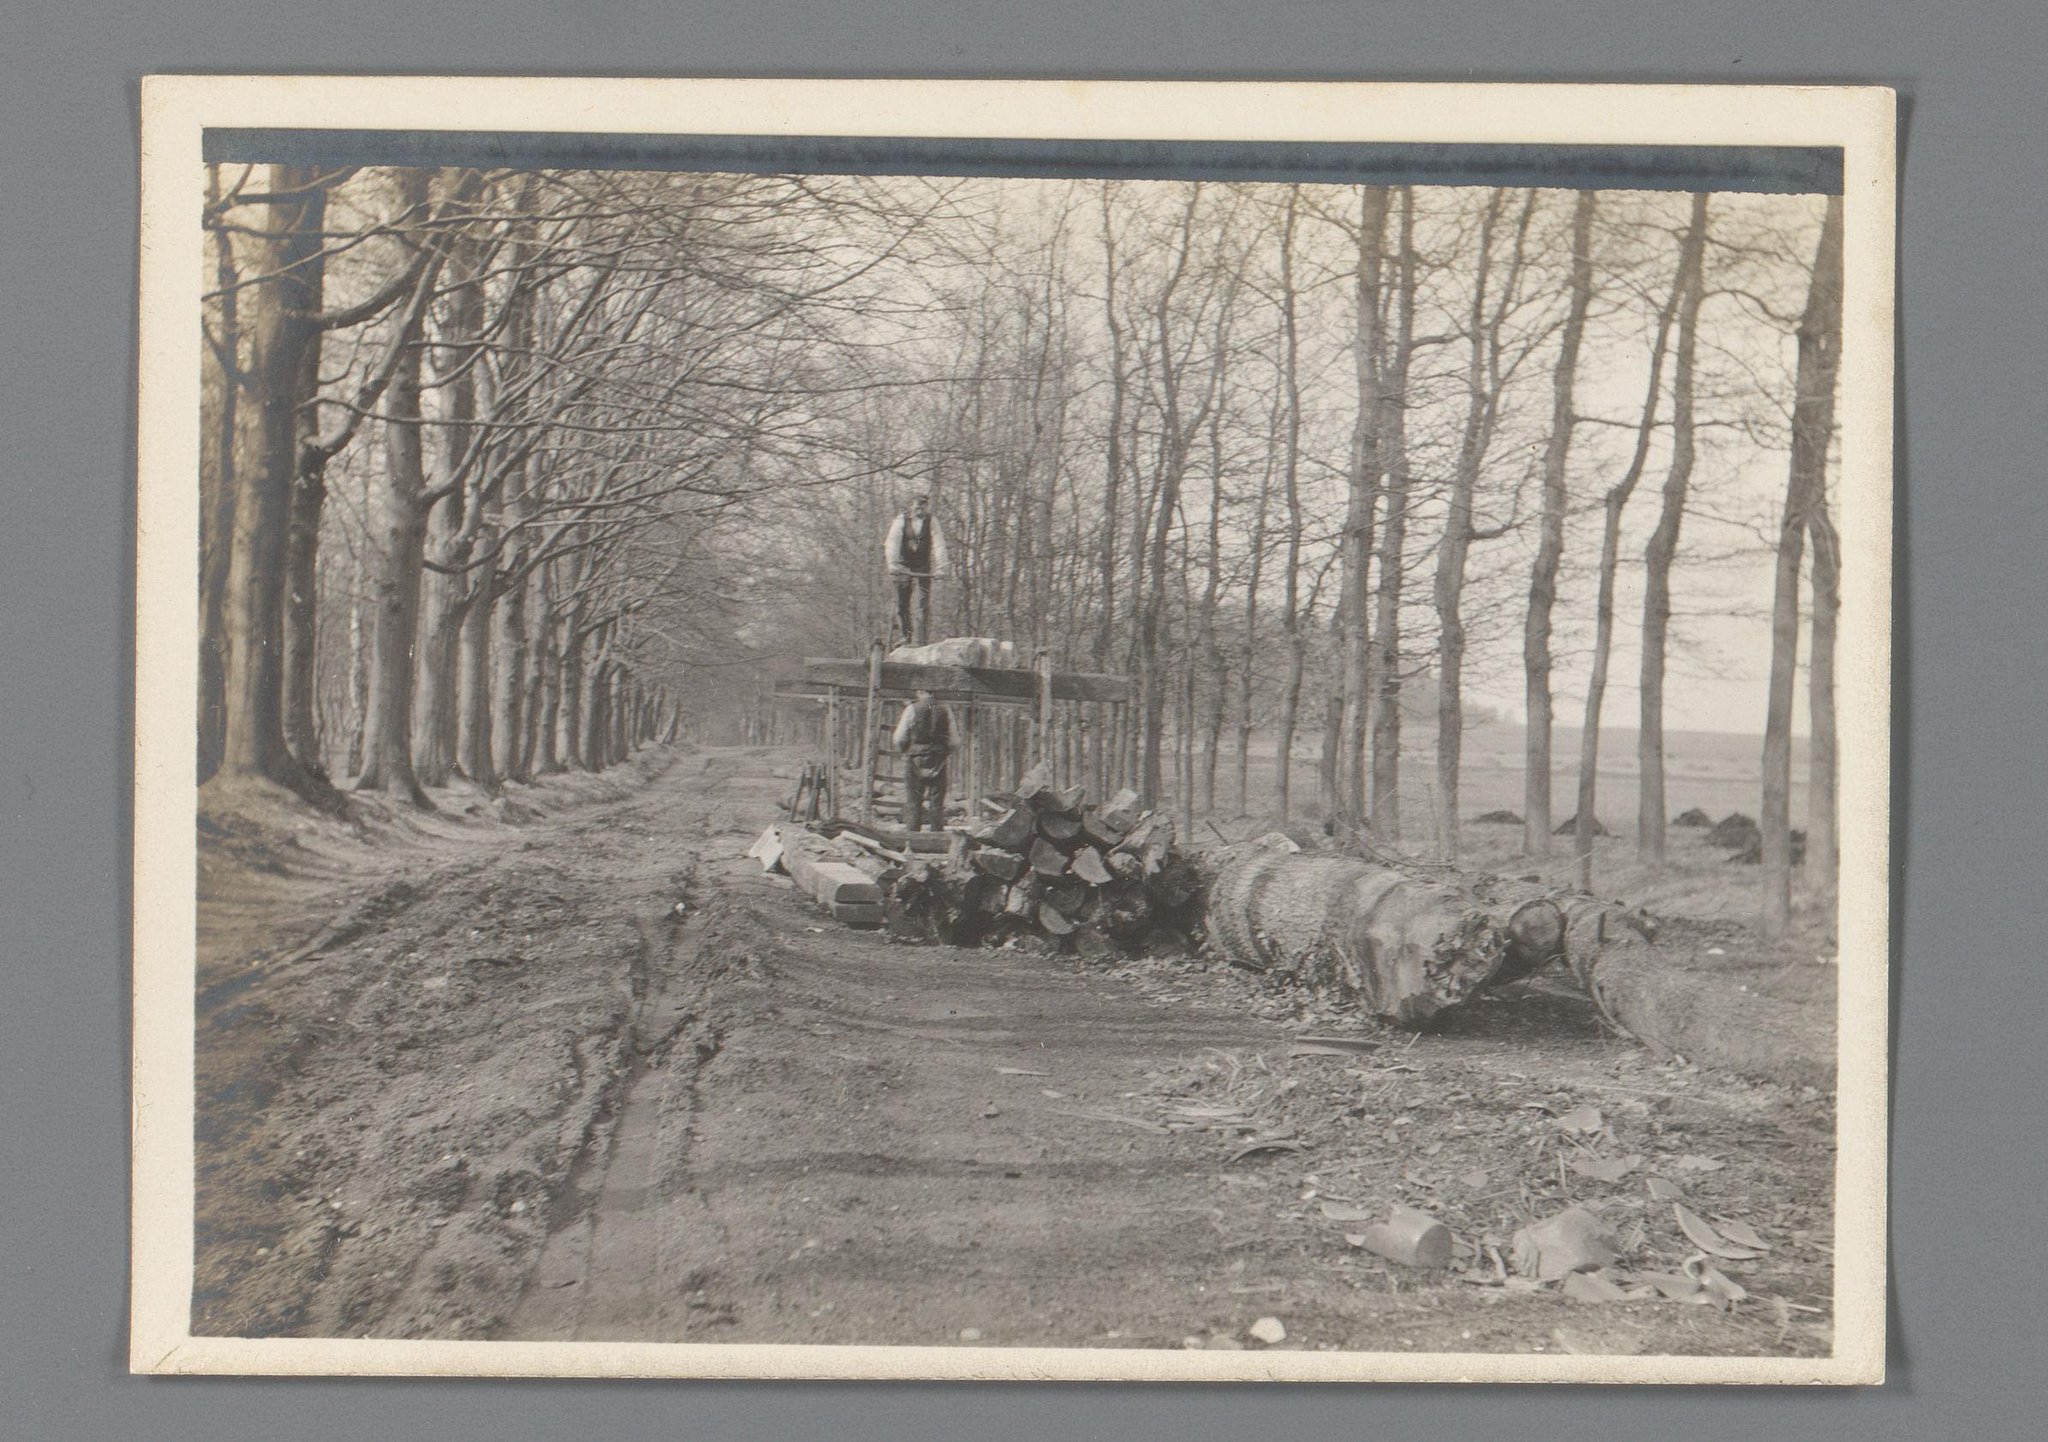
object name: photograph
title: Twee boomhakkers werkend in het bos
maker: willem de jong (fotograaf)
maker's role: arts, fotograaf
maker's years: 1864-1918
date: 1895-1918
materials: paper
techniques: gelatin silver print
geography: netherlands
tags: woodcutting, woodcutter ~ forestry, forest, wood